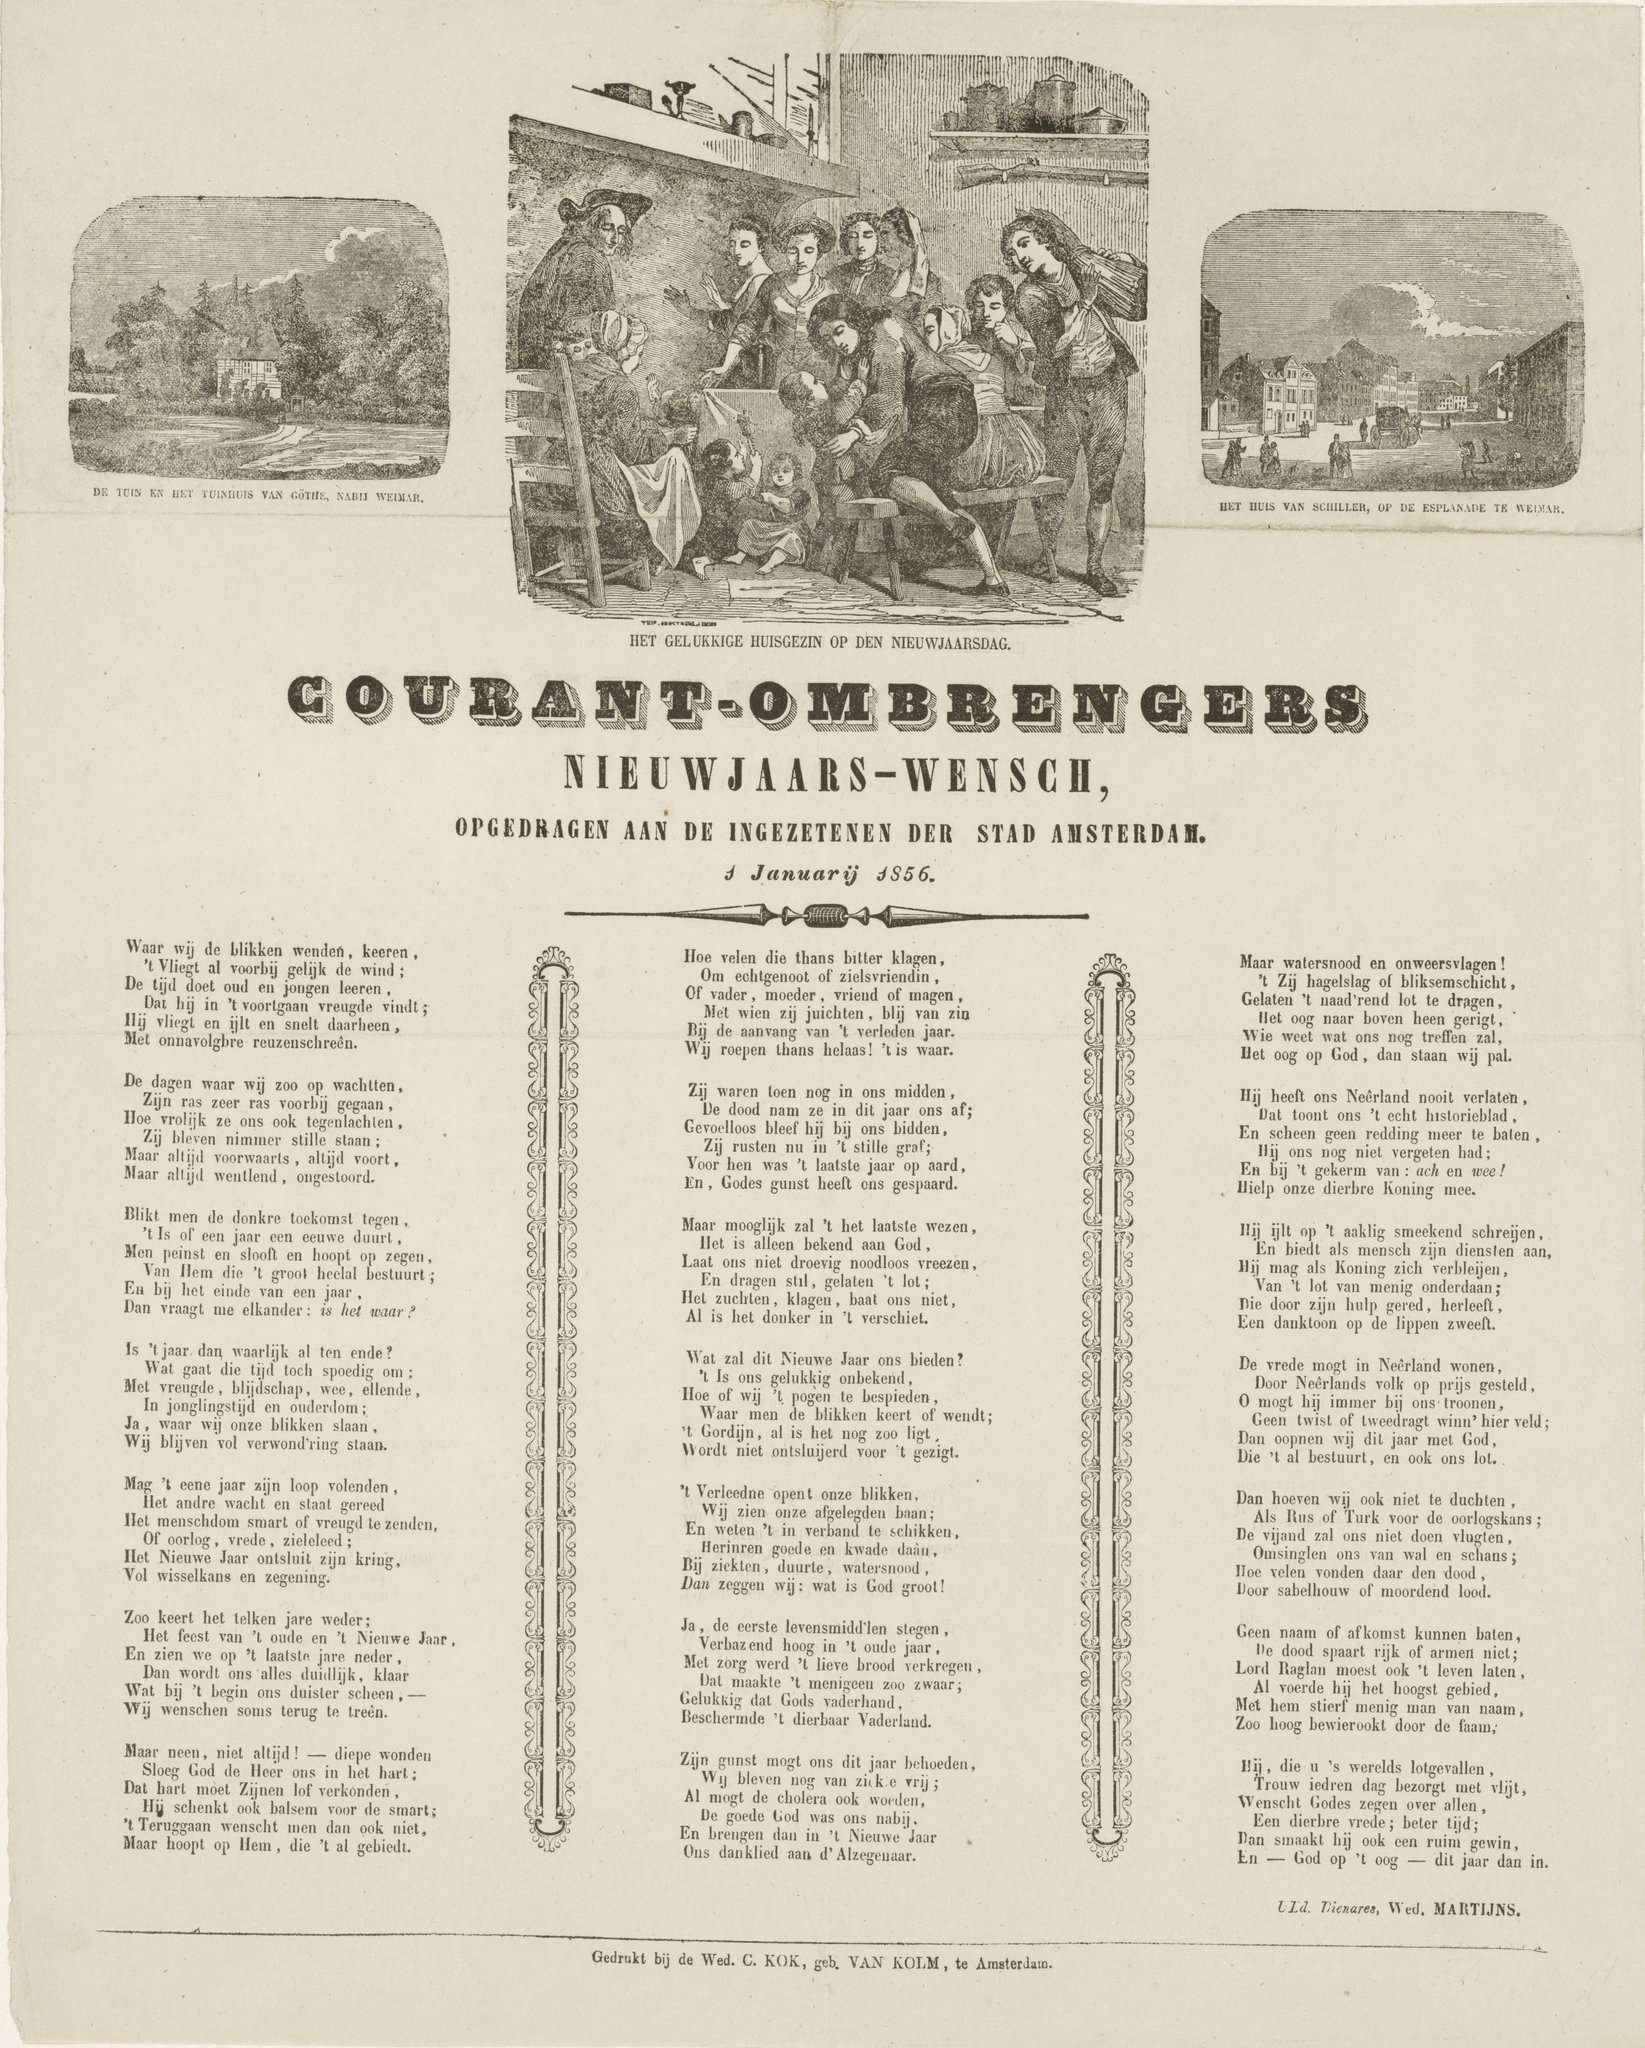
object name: new year card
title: Courant-ombrengers Nieuwjaars-Wensch (...) 1856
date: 1855-1856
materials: paper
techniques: letterpress printing, engraving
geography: amsterdam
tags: draughtsman, johann wolfgang von goethe, friedrich von schiller, january 1 (~ festivities)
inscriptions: collector's mark: Lugt 2228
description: Nieuwjaarswens namens de ombrengers van couranten (krantenbezorgers) te Amsterdam voor het jaar 1856. Bovenaan drie vignetten aan boeken ontleend, met centraal feest bij een gezin op Nieuwjaarsdag, links het huis van Goethe bij Weimar, rechts het huis van Schiller te Weimar. Onderaan een gedicht in drie kolommen. Van de courantombrengster: wed. Martijns.